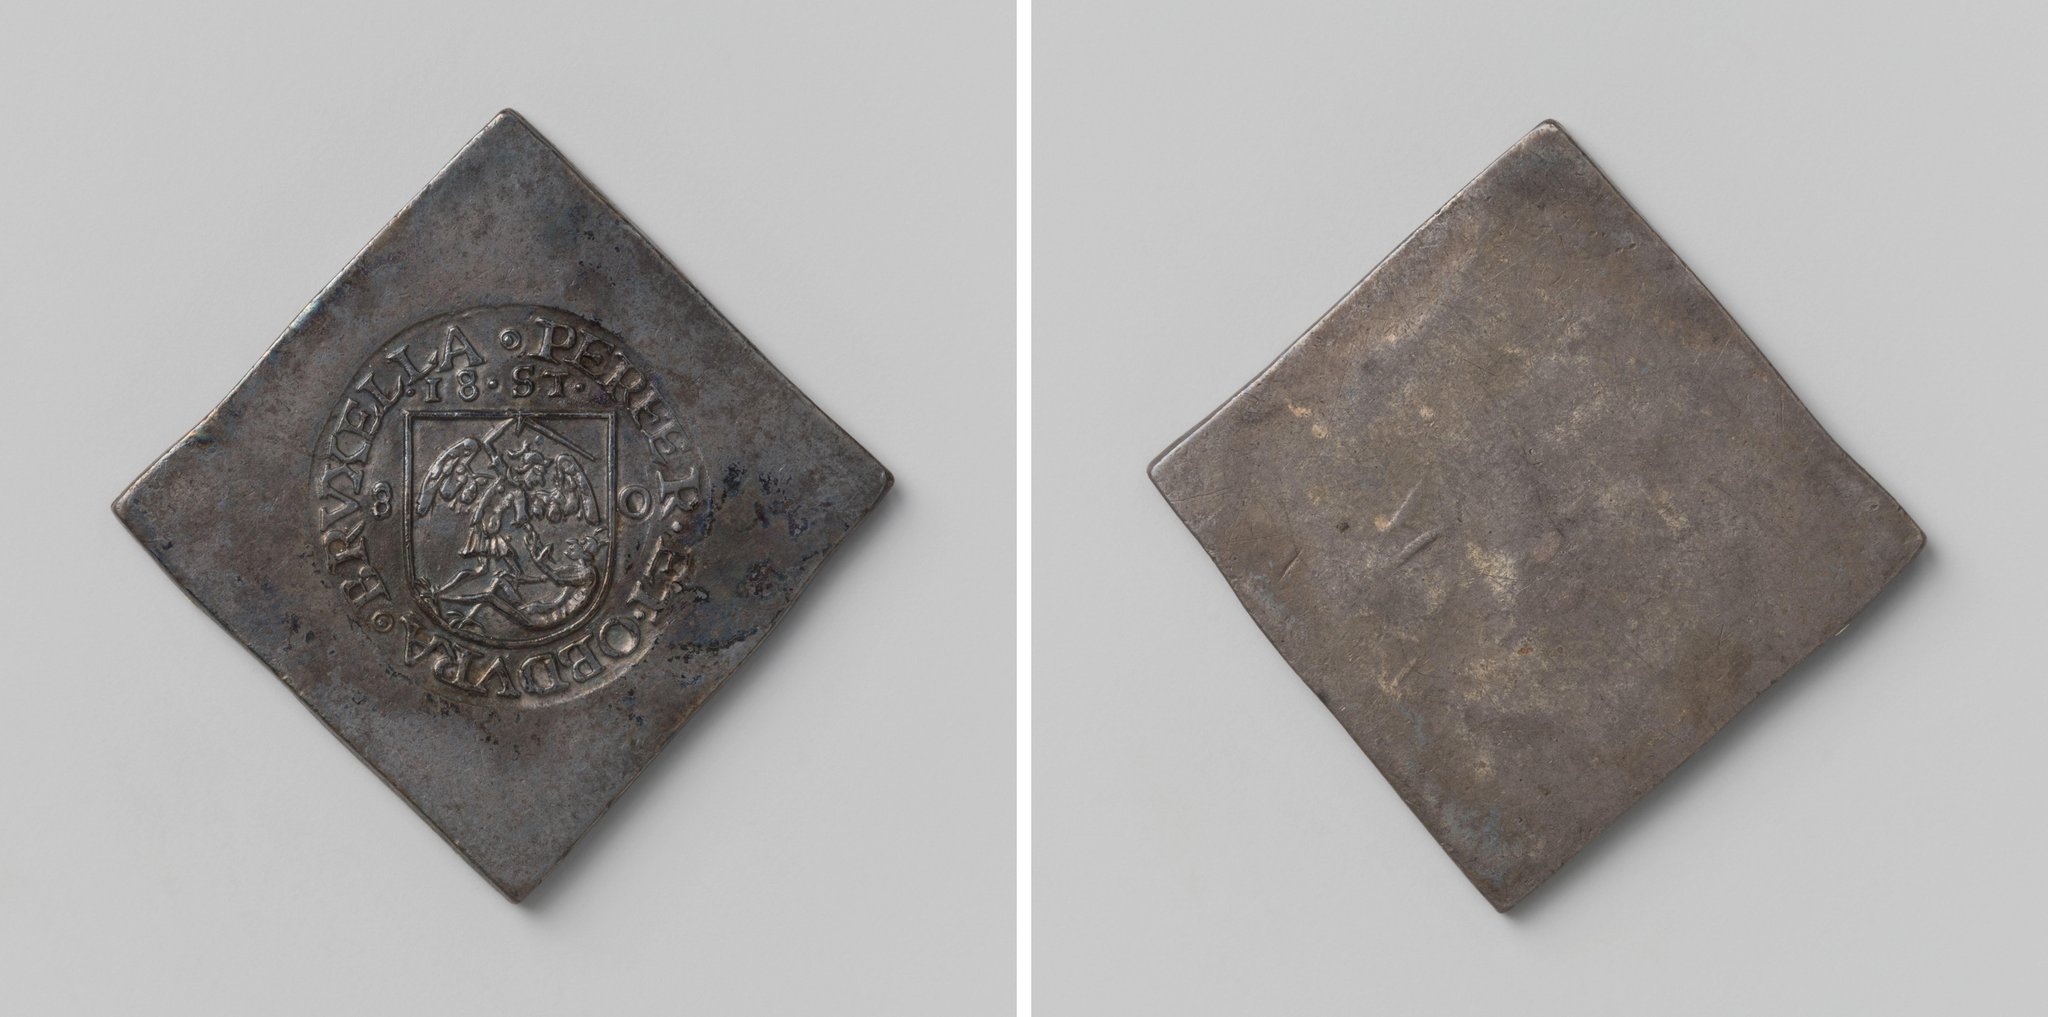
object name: achttien stuiver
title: Achttien stuiver, noodmunt uit Brussel, door de Spaanse troepen afgesneden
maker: Anonymous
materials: silver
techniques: striking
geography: brussels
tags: brussels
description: Achttien stuivers; eenzijdige zilveren ruitvormige noodmunt. Voorzijde: een ronde stempel: wapenschild onder waardeaanduiding, tussen cijfers 8 en 0 binnen omschrift. Keerzijde: blanco.